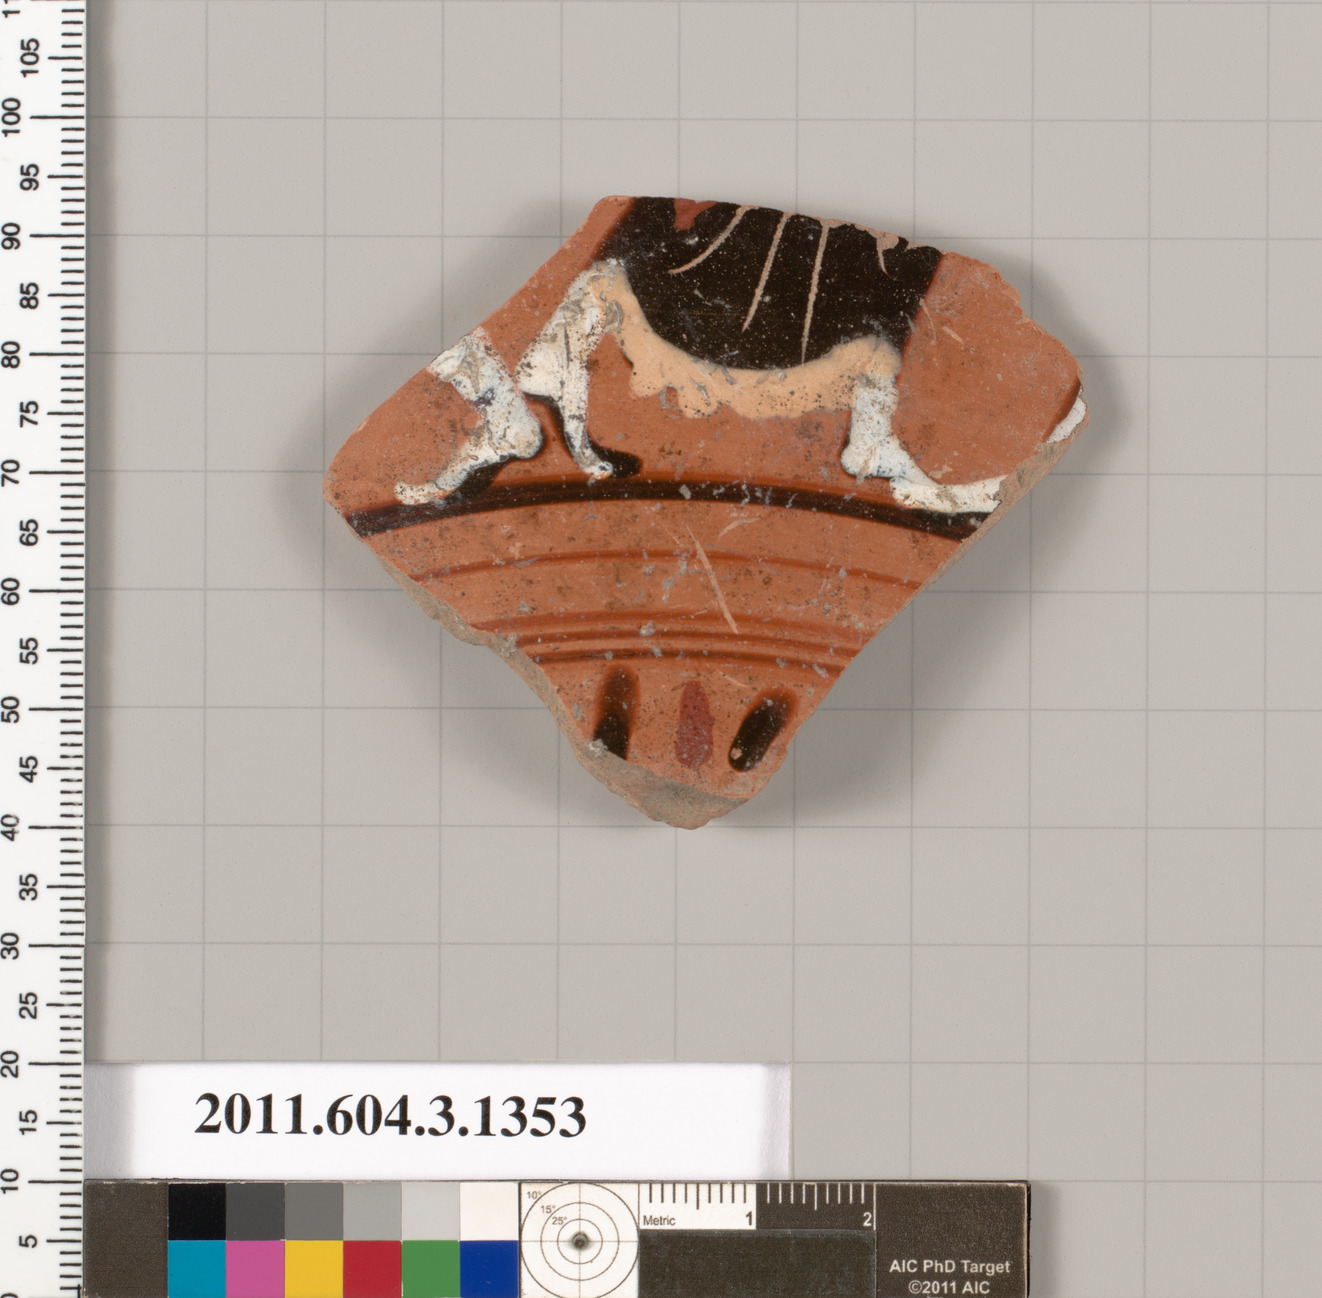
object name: skyphos fragment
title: Terracotta fragment of a skyphos (deep drinking cup)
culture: greek, attic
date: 500-468 BCE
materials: terracotta